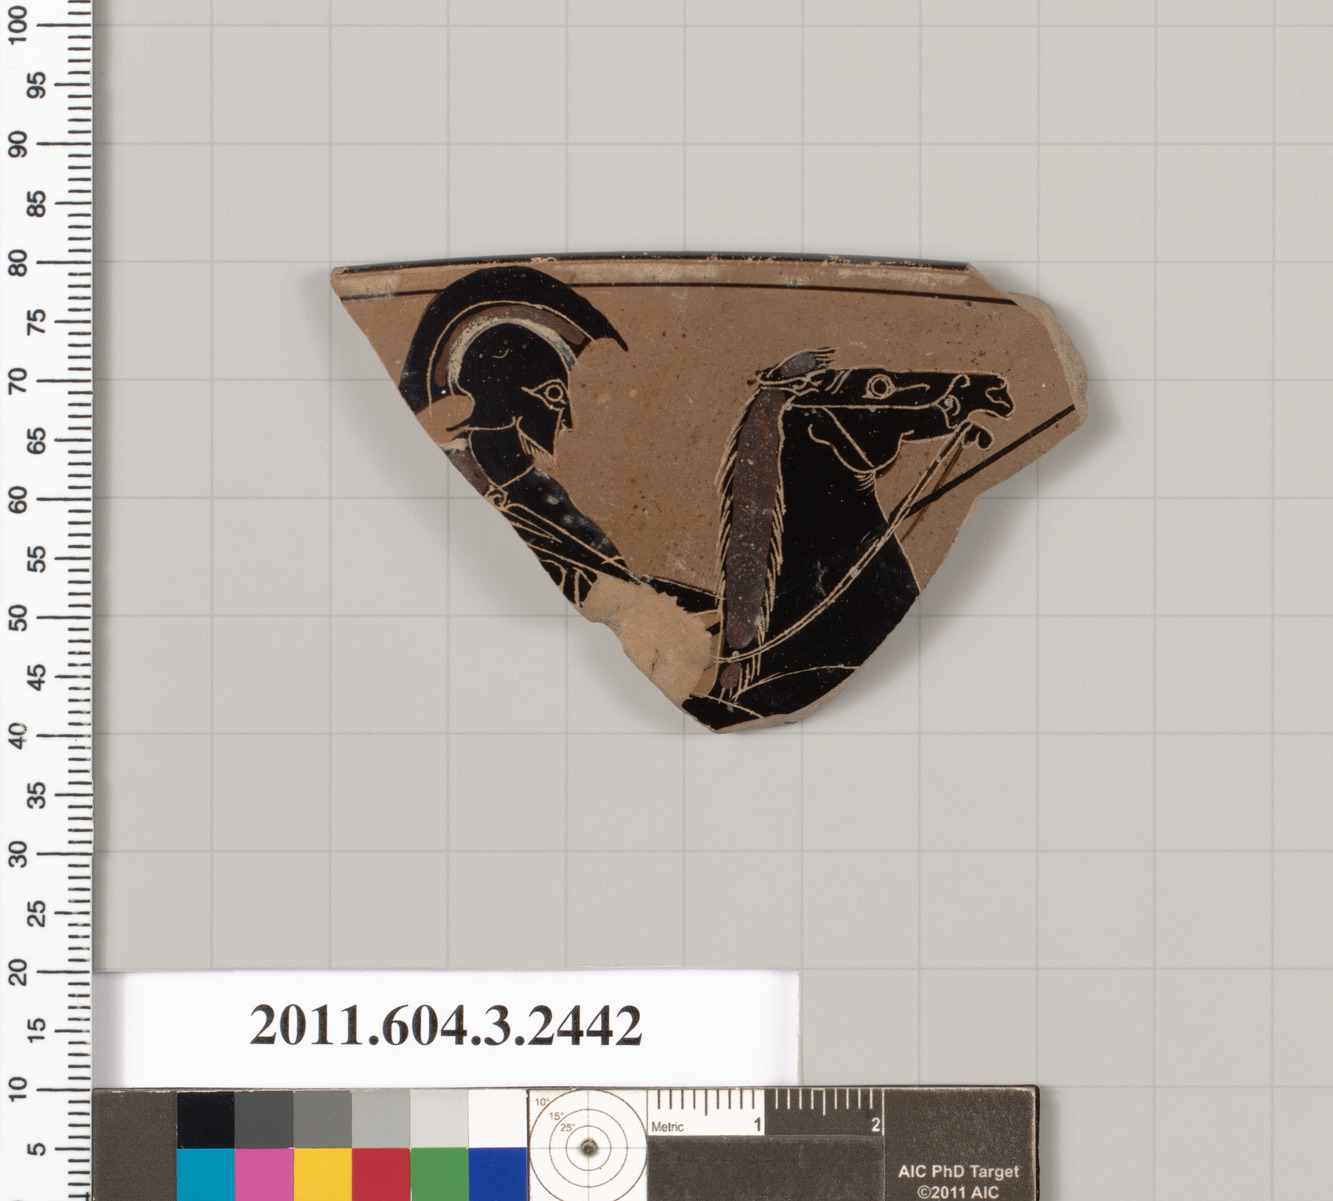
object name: kylix fragment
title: Terracotta rim fragment of a kylix (drinking cup)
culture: greek, attic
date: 530-510 BCE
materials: terracotta